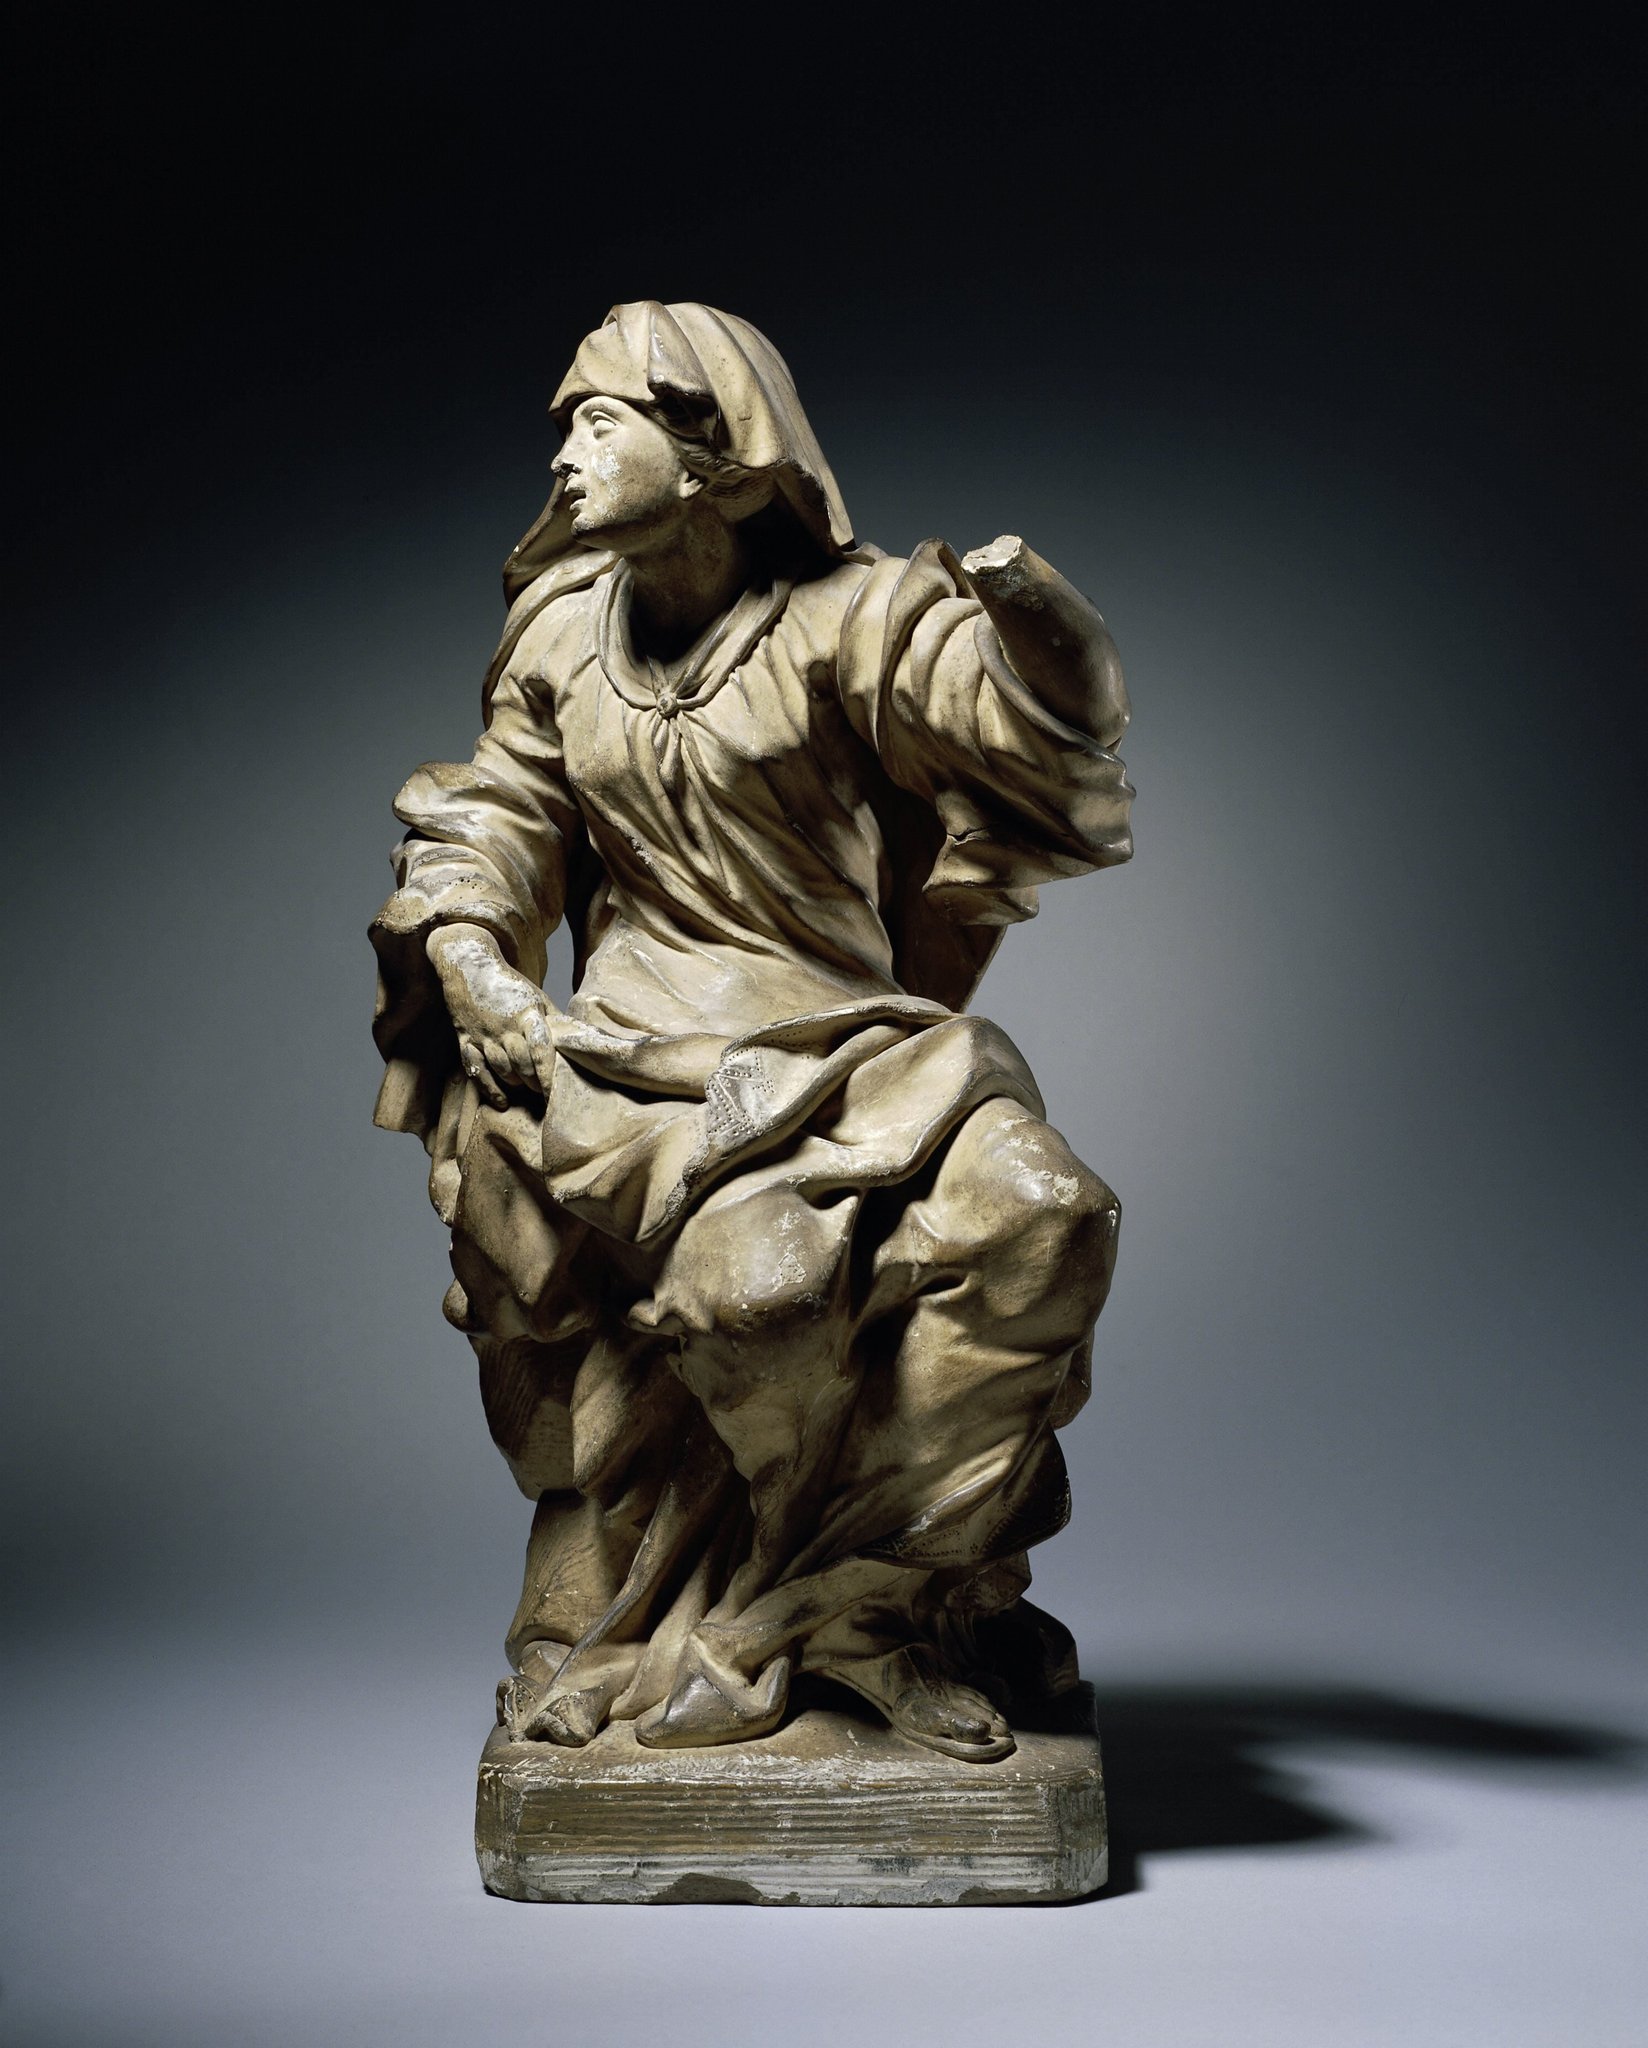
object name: sculpture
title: Hoop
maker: willem hendrik van der wall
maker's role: sculptor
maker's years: 1716-1790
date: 1776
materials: terracotta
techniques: modeling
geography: utrecht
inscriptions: signature and date: ‘H.W. VAN DE WALL fc 1776’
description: Willem Hendrik van de Wall (1716 - 1790). Faith, Hope and Charity. Terracotta. Utrecht, 1775 and 1776.